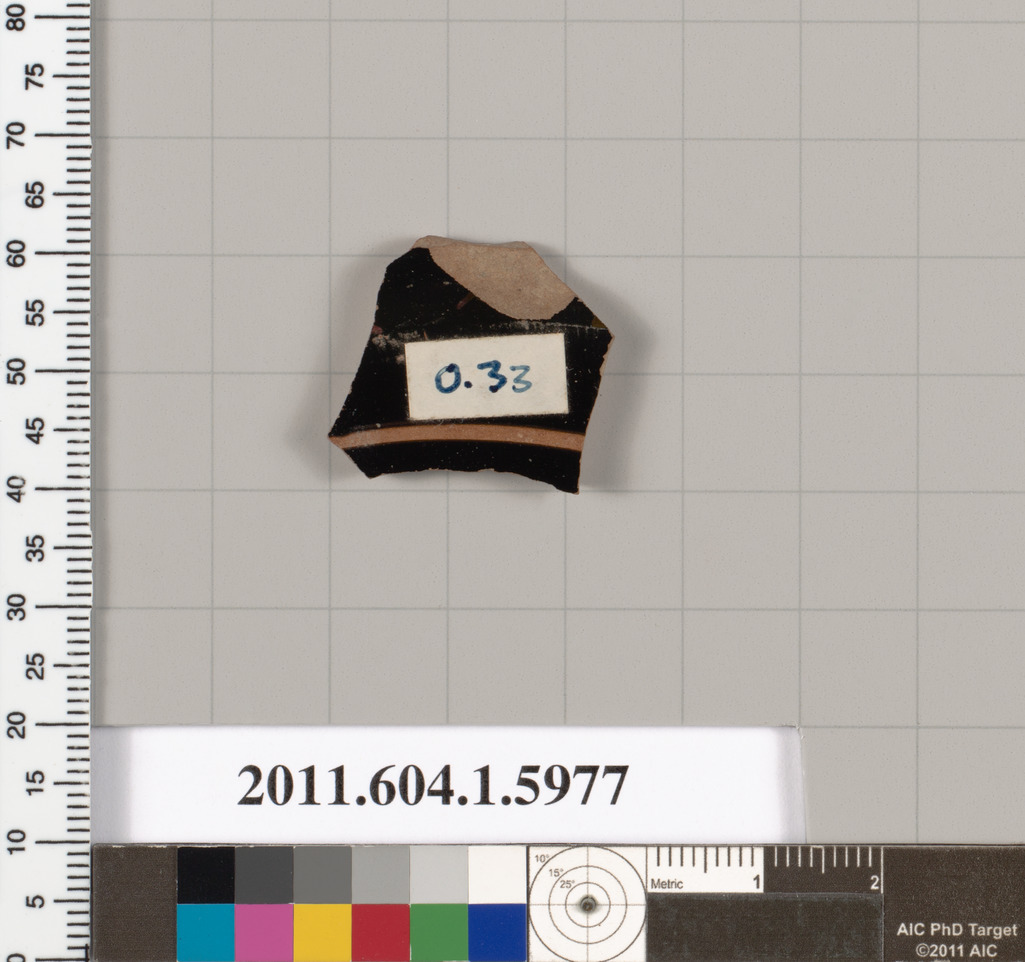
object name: kylix fragment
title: Terracotta fragment of a kylix (drinking cup)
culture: greek, attic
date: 433-567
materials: terracotta